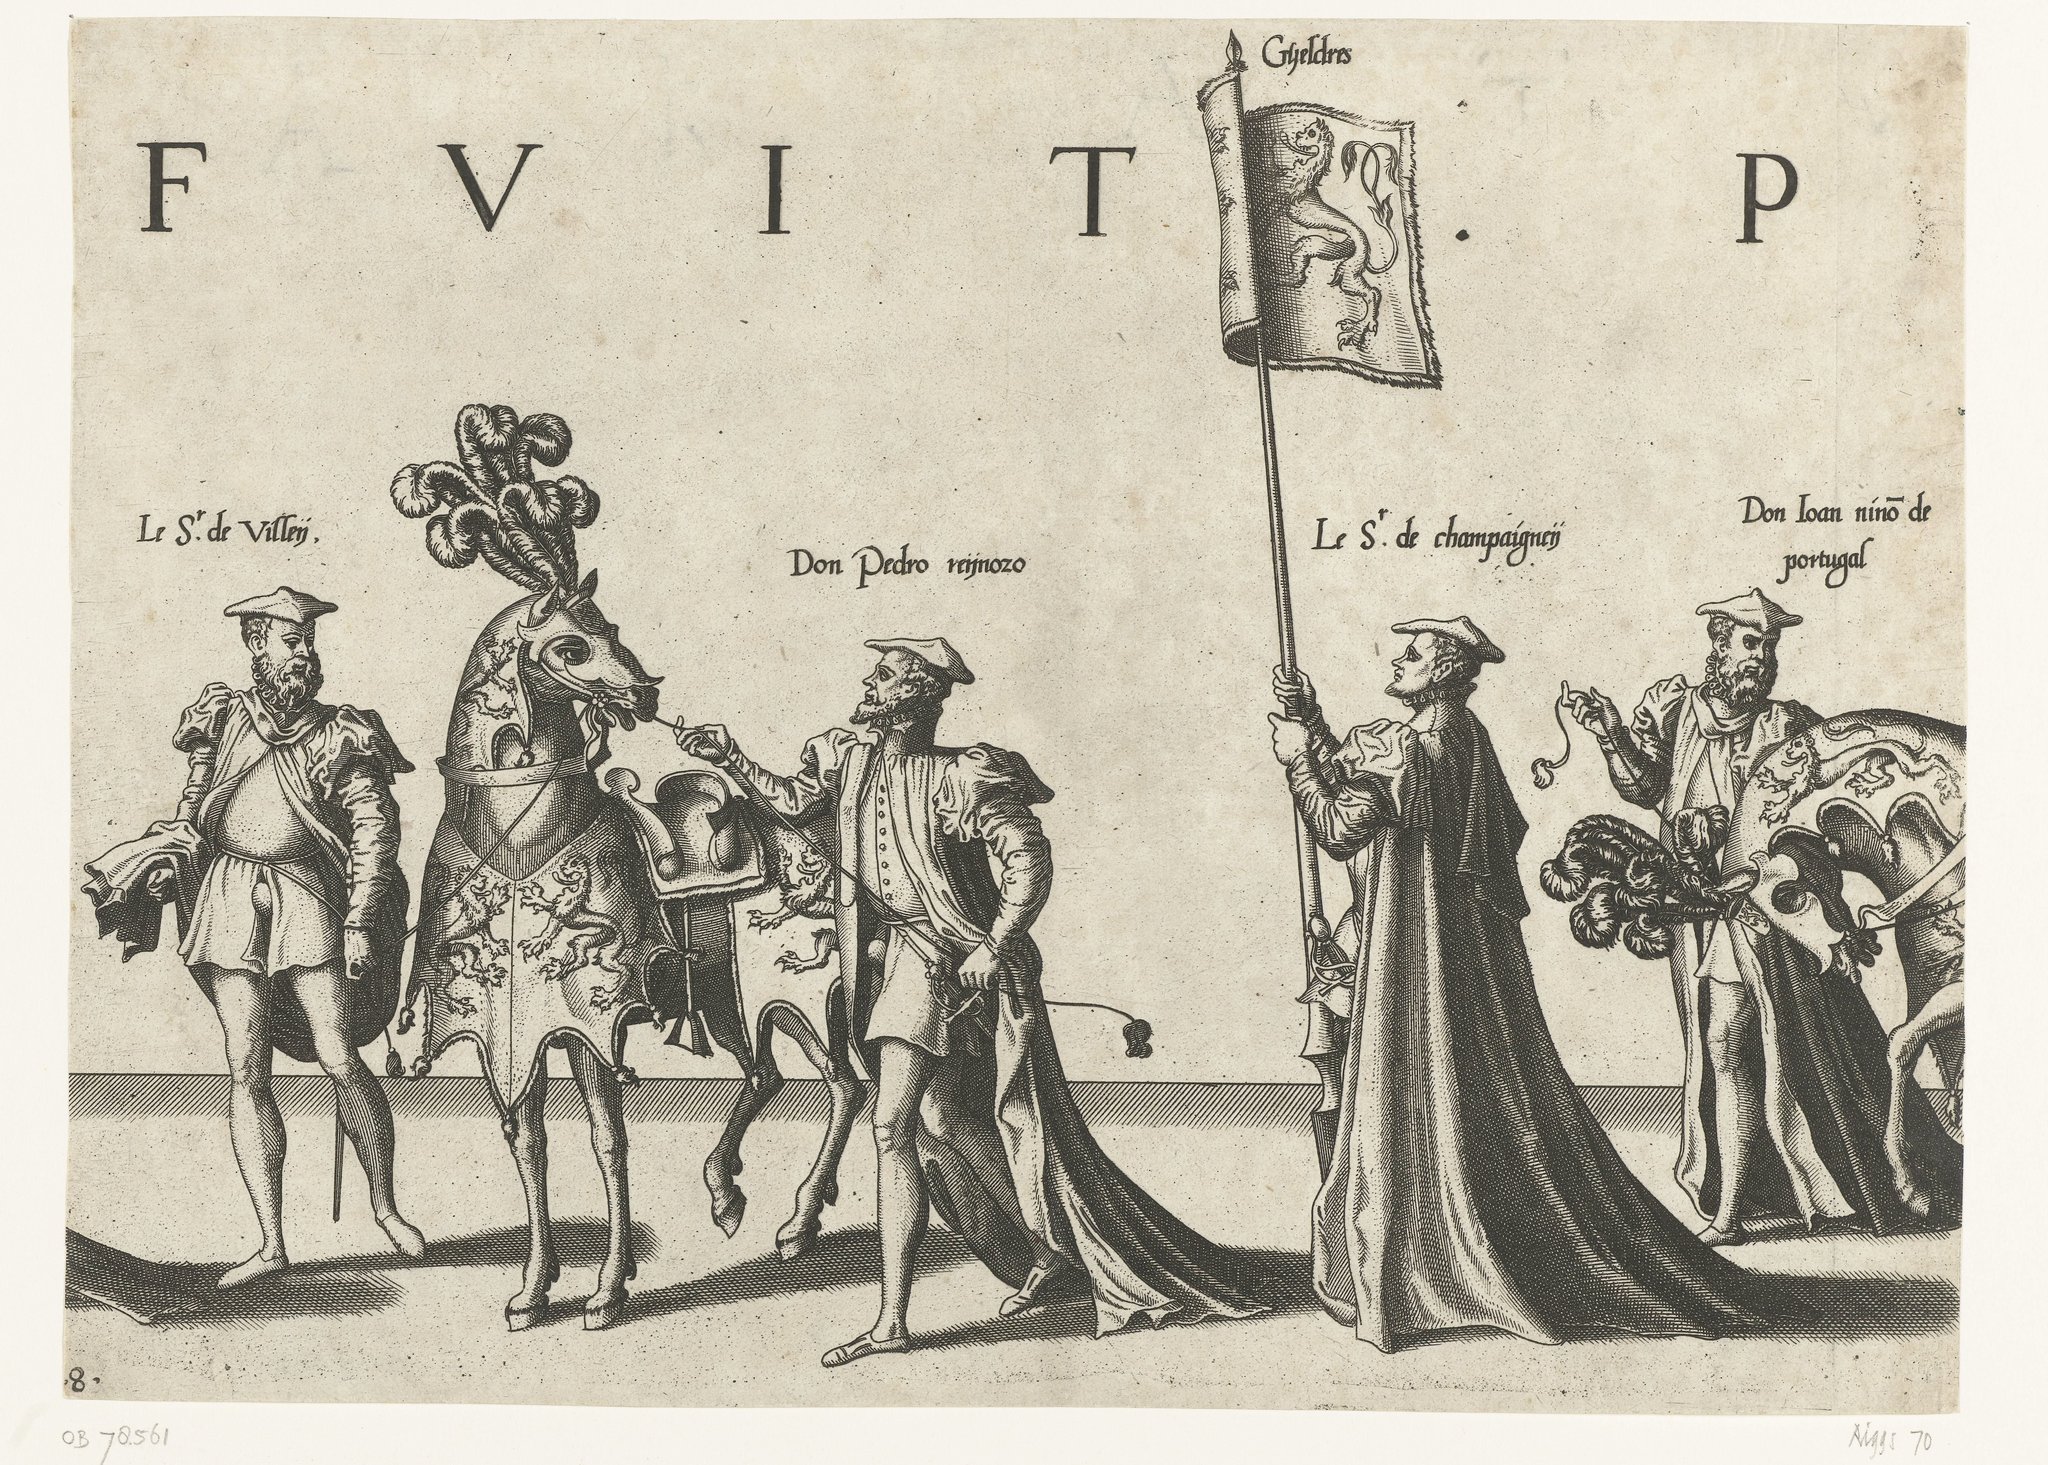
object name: print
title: La magnifique, et sumptueuse Pompe Funebre, faite aus Obseques & Funerailles du tres-grand & tres-victorieus Empereur Charles Cinquième, Celebrées en la Vile de Bruxelles le XXIX. Iour du Mois de Decembre M.D.LVIII. par Philippes Roy Catholique d'Espaignes son Fils.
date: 1559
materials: paper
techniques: engraving, etching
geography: southern netherlands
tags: charles v (holy roman emperor and king of spain), cortege, funeral procession, brussels, guelders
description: Vier deelnemers aan de optocht, paarden en het vaandel met het wapen van Gelre. Onderdeel van de prentreeks van de Begrafenisoptocht van keizer Karel V op 29 december 1558 te Brussel.